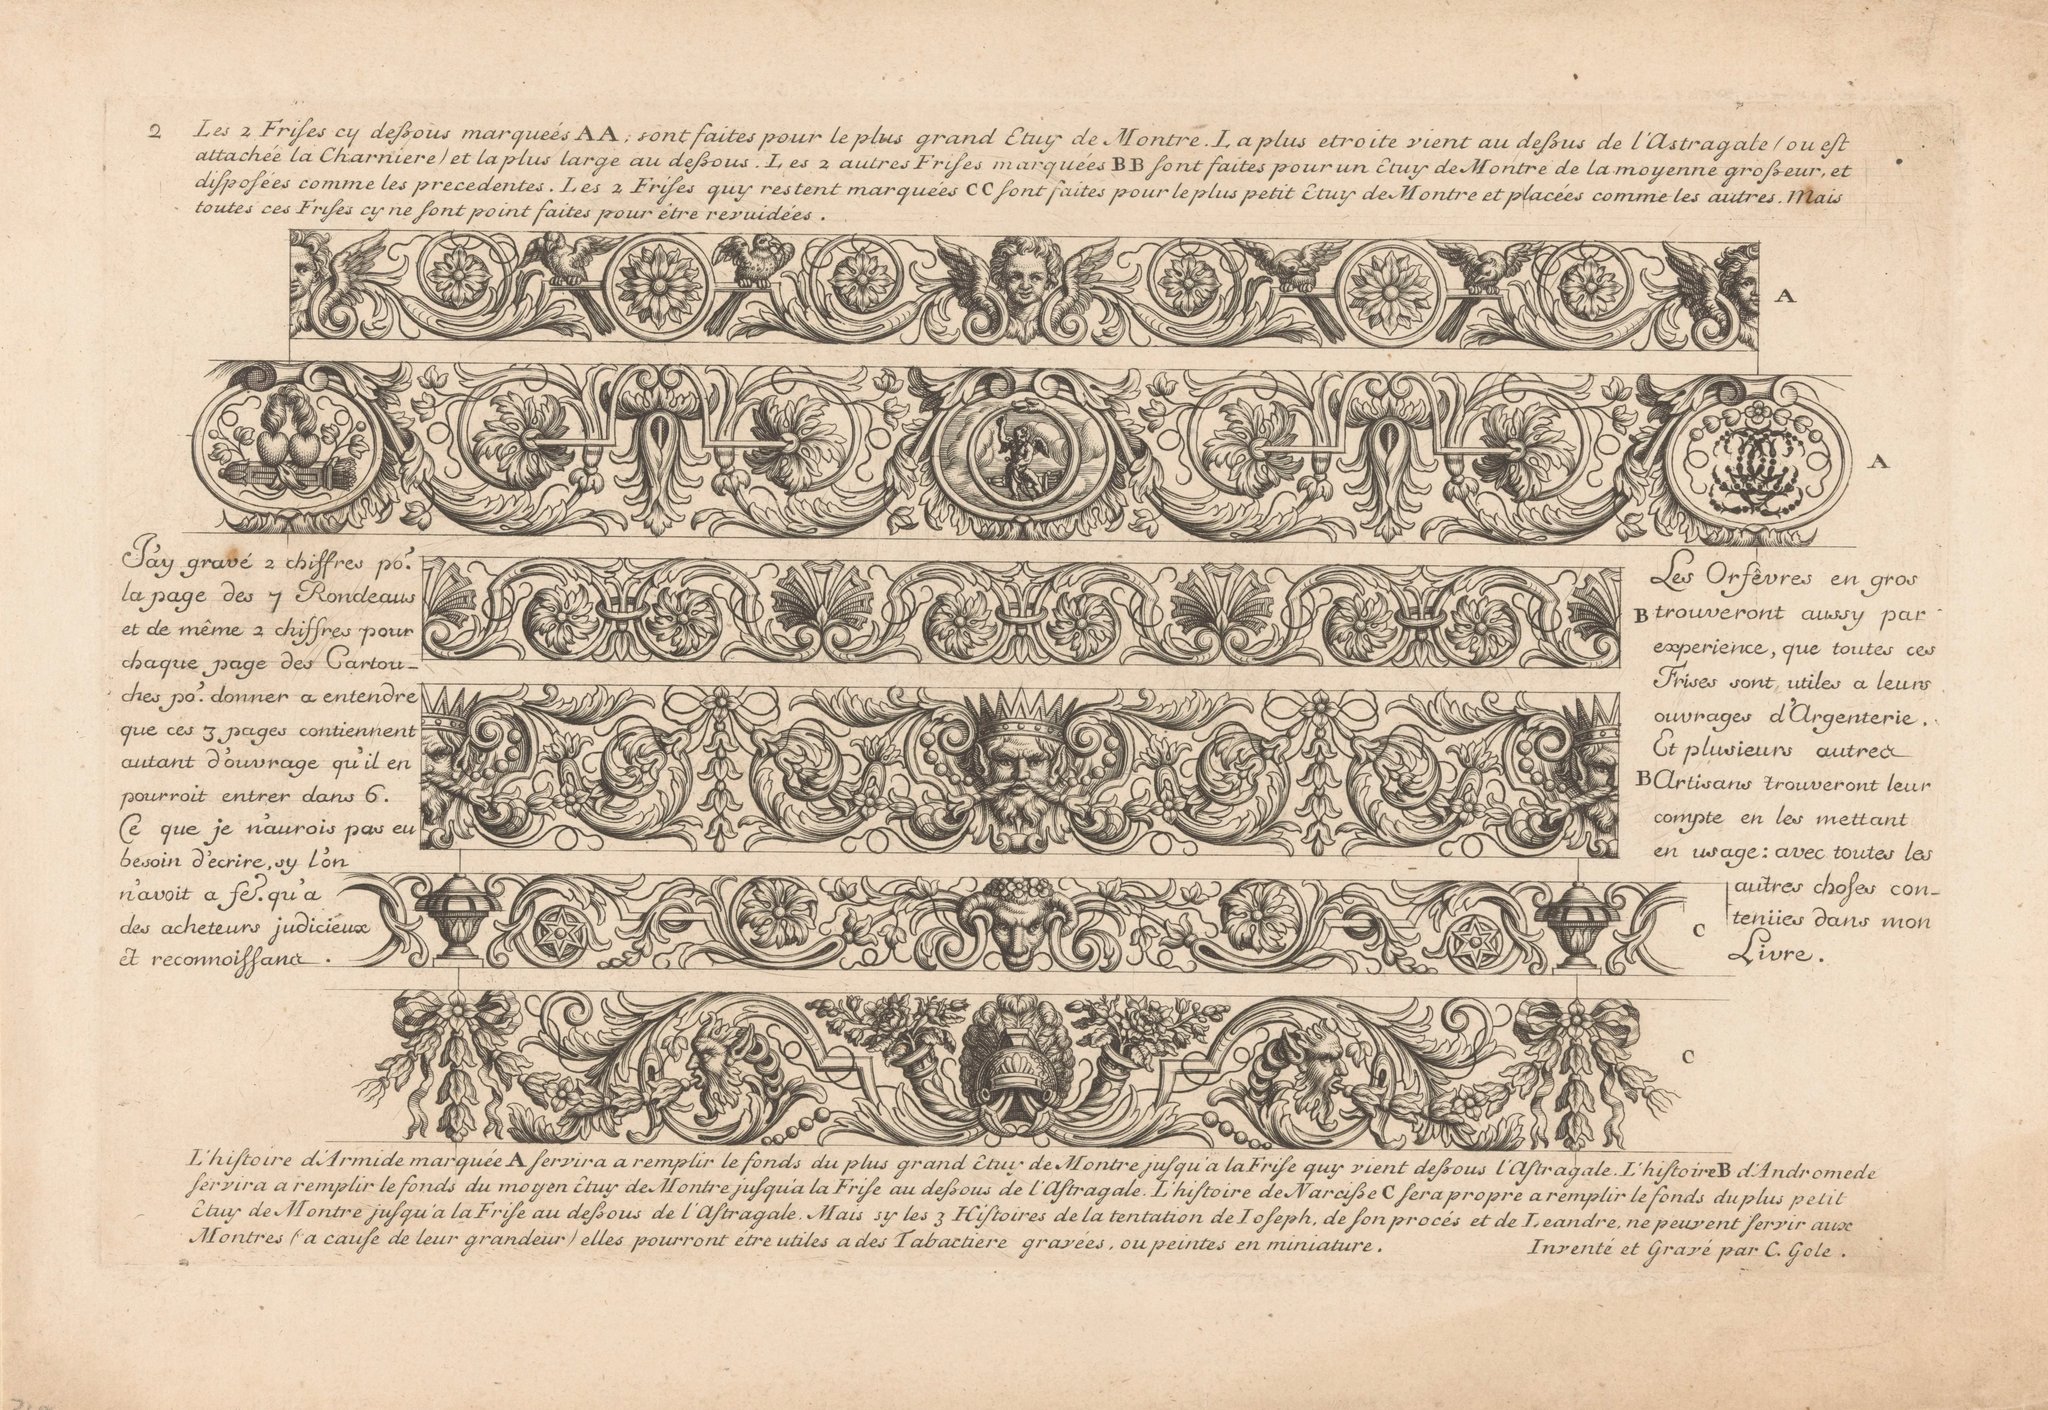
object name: print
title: Zes friezen met putti, vogels, maskers en een helm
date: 1737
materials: paper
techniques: engraving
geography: london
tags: helmet, ornament ~ arabesque, birds, mask, mascaron ~ ornament, cupids: 'amores', 'amoretti', 'putti'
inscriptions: collector's mark: Lugt 2228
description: Zes friezen gedecoreerd met arabesken, putti, vogels, maskers van een man met een kroon, een bokkenkop, vazen en een helm. Met Franse beschrijving.